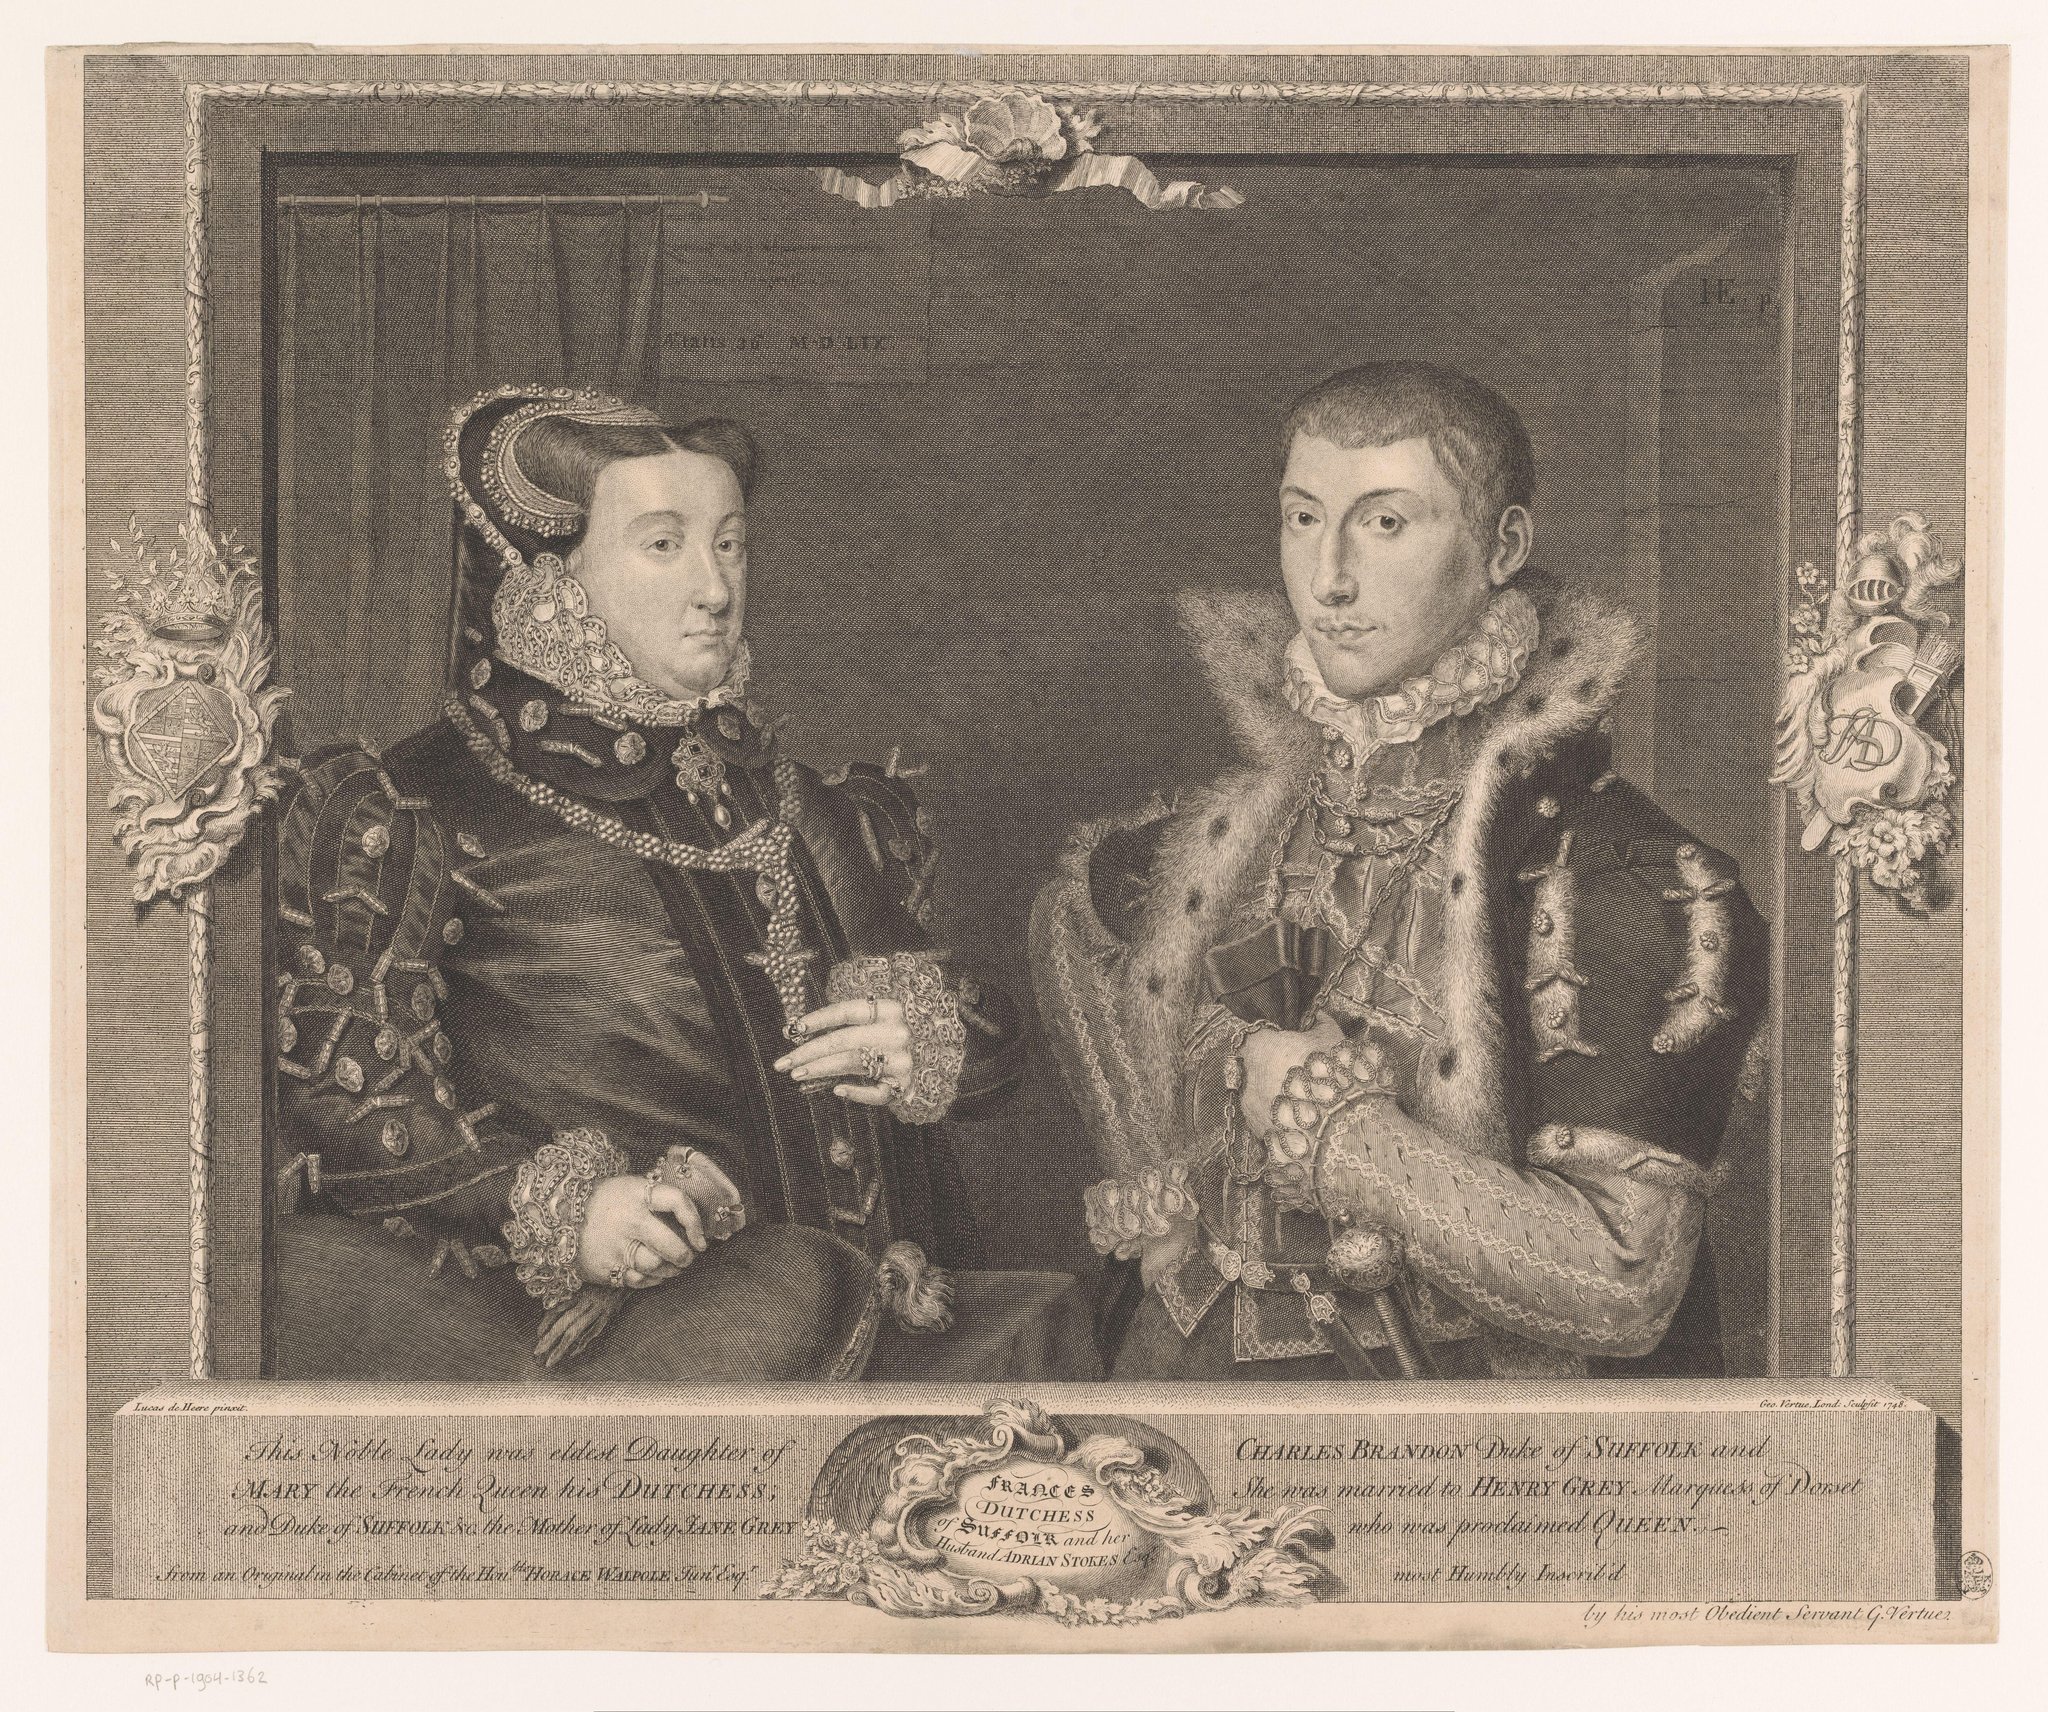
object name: print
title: Frances Dutchess of Suffolk and her husband Adrian Stokes Esqr.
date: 1748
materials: paper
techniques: etching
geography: london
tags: mother and son(s) (family group), gloves, mittens, etc., historical person in a double portrait, historical person - woman - in a double portrait, necklace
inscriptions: collector's mark: Lugt 2228, collector's mark: Lugt 1618, collector's mark: Lugt 1647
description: Prent is naar een schilderij van Hans Ewouts en niet naar Lukas de Heere, zoals op de prent vermeld. Het portret is niet van Frances Brandon en haar tweede man Adrian Stokes, maar van Mary Fiennes en haar zoon Gregory Fiennes. Prent hoort bij een serie van negen prenten naar portretten van de Tudor-familie. De eerste vier werden in 1743 uitgegeven. In 1748 werden weer vier prenten gepubliceerd en in 1750 een laatste.